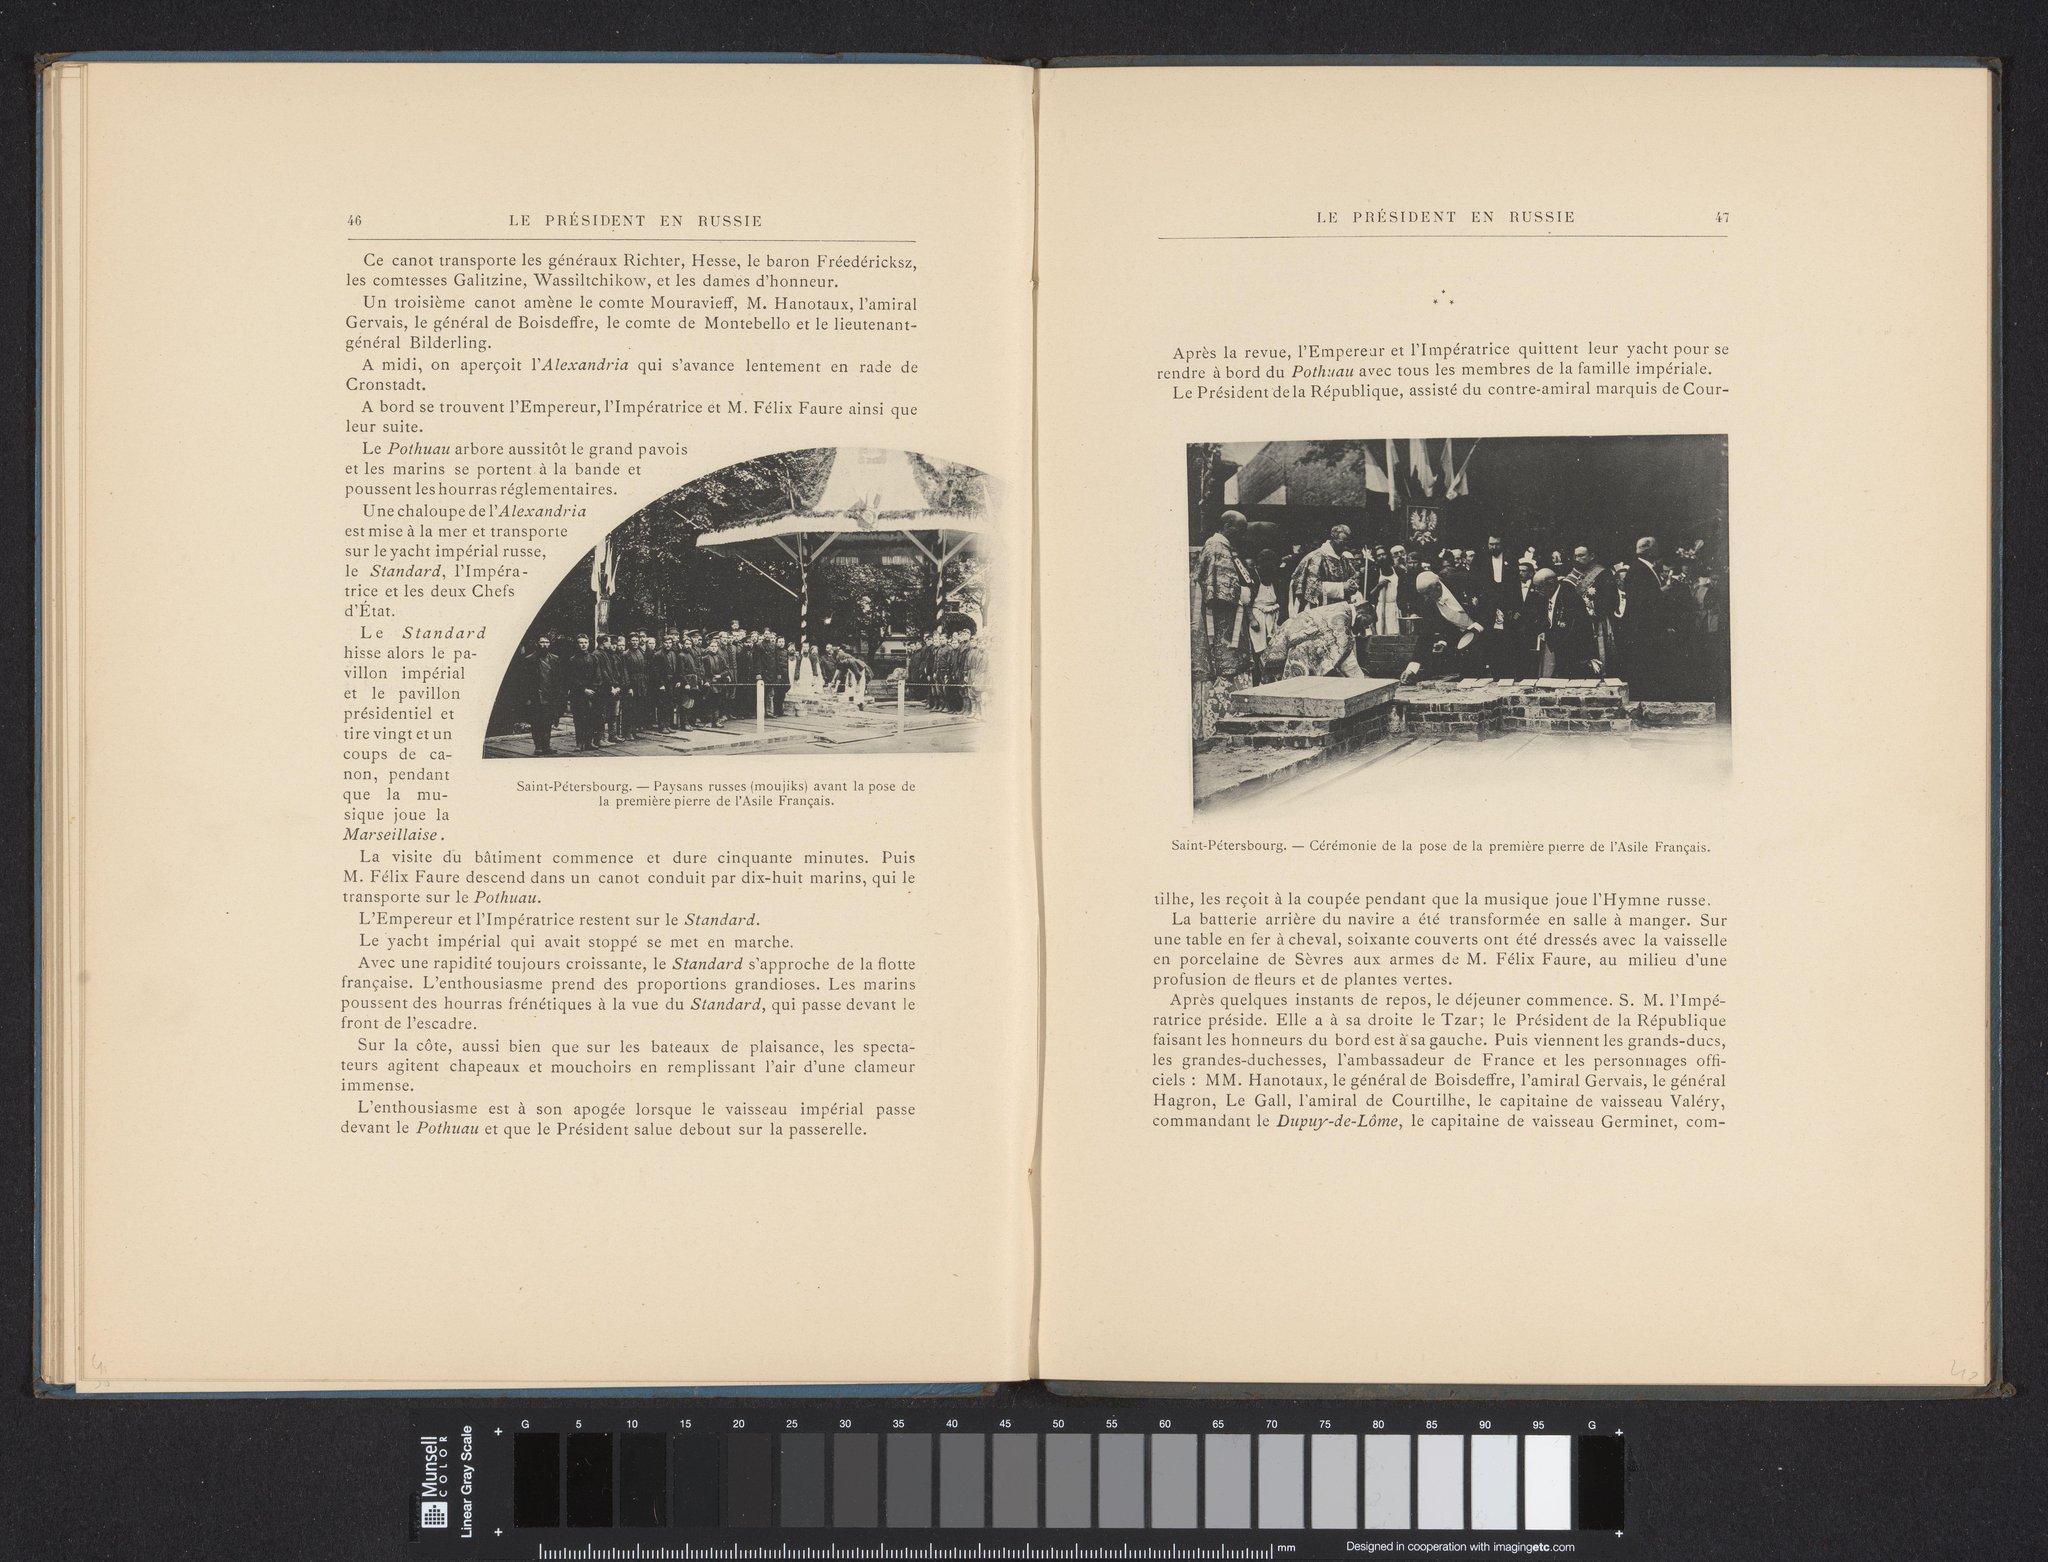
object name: photomechanical print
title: Leggen van de eerste steen van een Frans opvangcentrum te Sint-Petersburg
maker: Anonymous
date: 1897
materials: paper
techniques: photograph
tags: ceremonial laying of the foundations, laying the first stone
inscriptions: inscription: ‘Saint-Pétersbourg.- (...) l'Asile Français.’